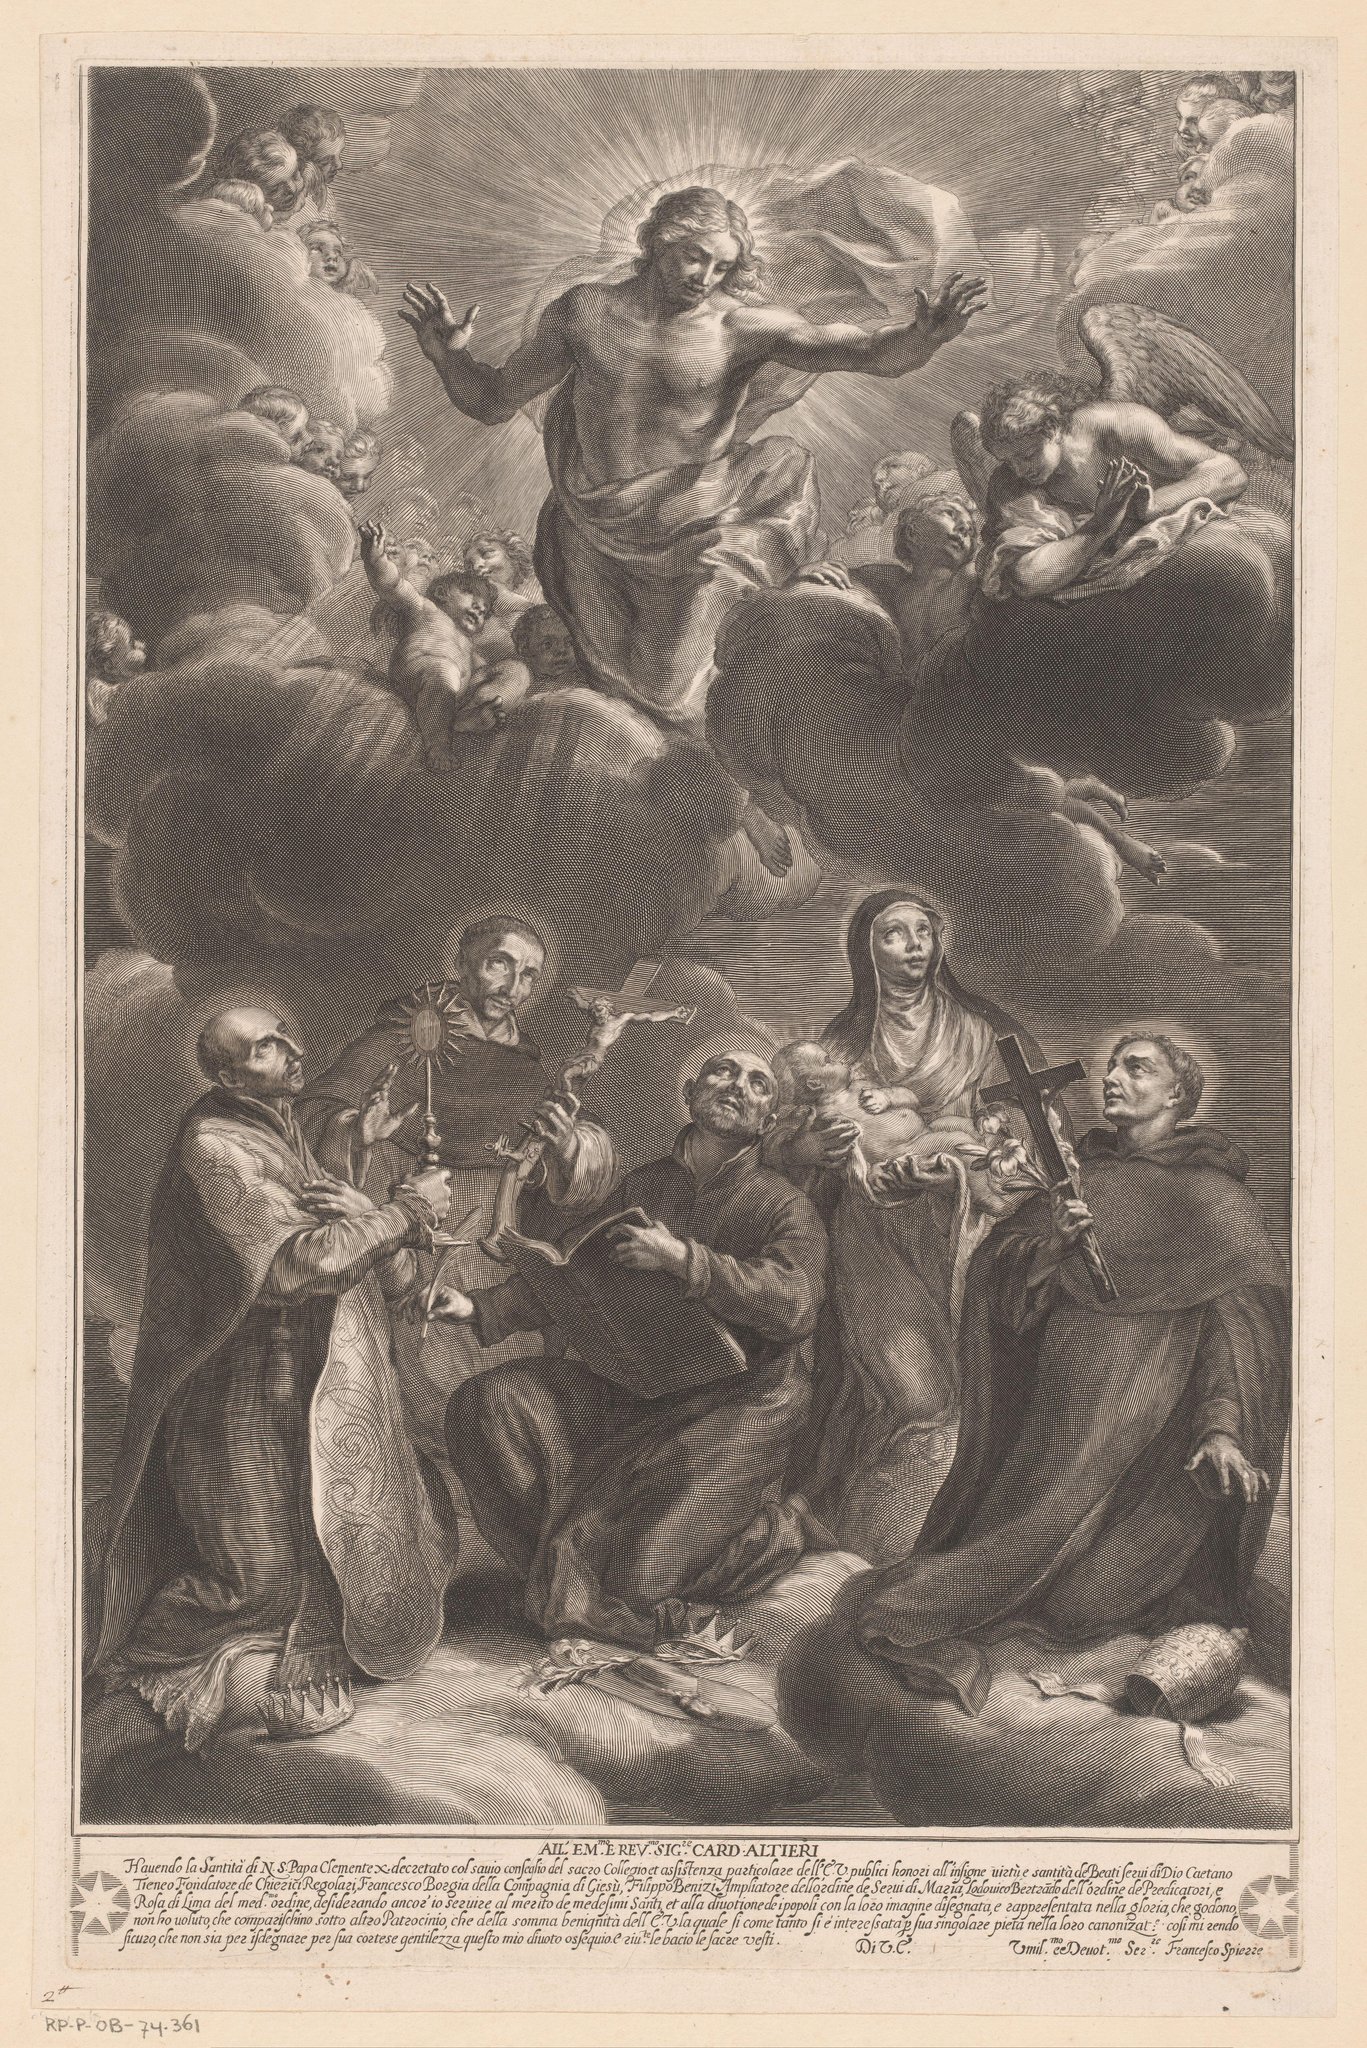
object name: print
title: Vijf heiligen aanbidden Christus, die omringd door engelen in de hemel boven hen verschijnt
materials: paper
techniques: engraving, etching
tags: christ (+ angel(s)), adult christ together with apostles, evangelists, saints, etc., the dominican tertiary rosa (rose) of lima; possible attributes: anchor, crown of thorns, crucifix, infant christ (in her arms or on a bunch of roses), lily, (wreath of) roses, francis borgia, jesuit priest and duke of gandia; possible attributes: book, ducal hat, monstrance, skull with crown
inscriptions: collector's mark: Lugt 240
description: De heiligen zijn Francis Borgia, Louis Bertrand, Cajetan, Rosa van Lima en Philip Benizi.